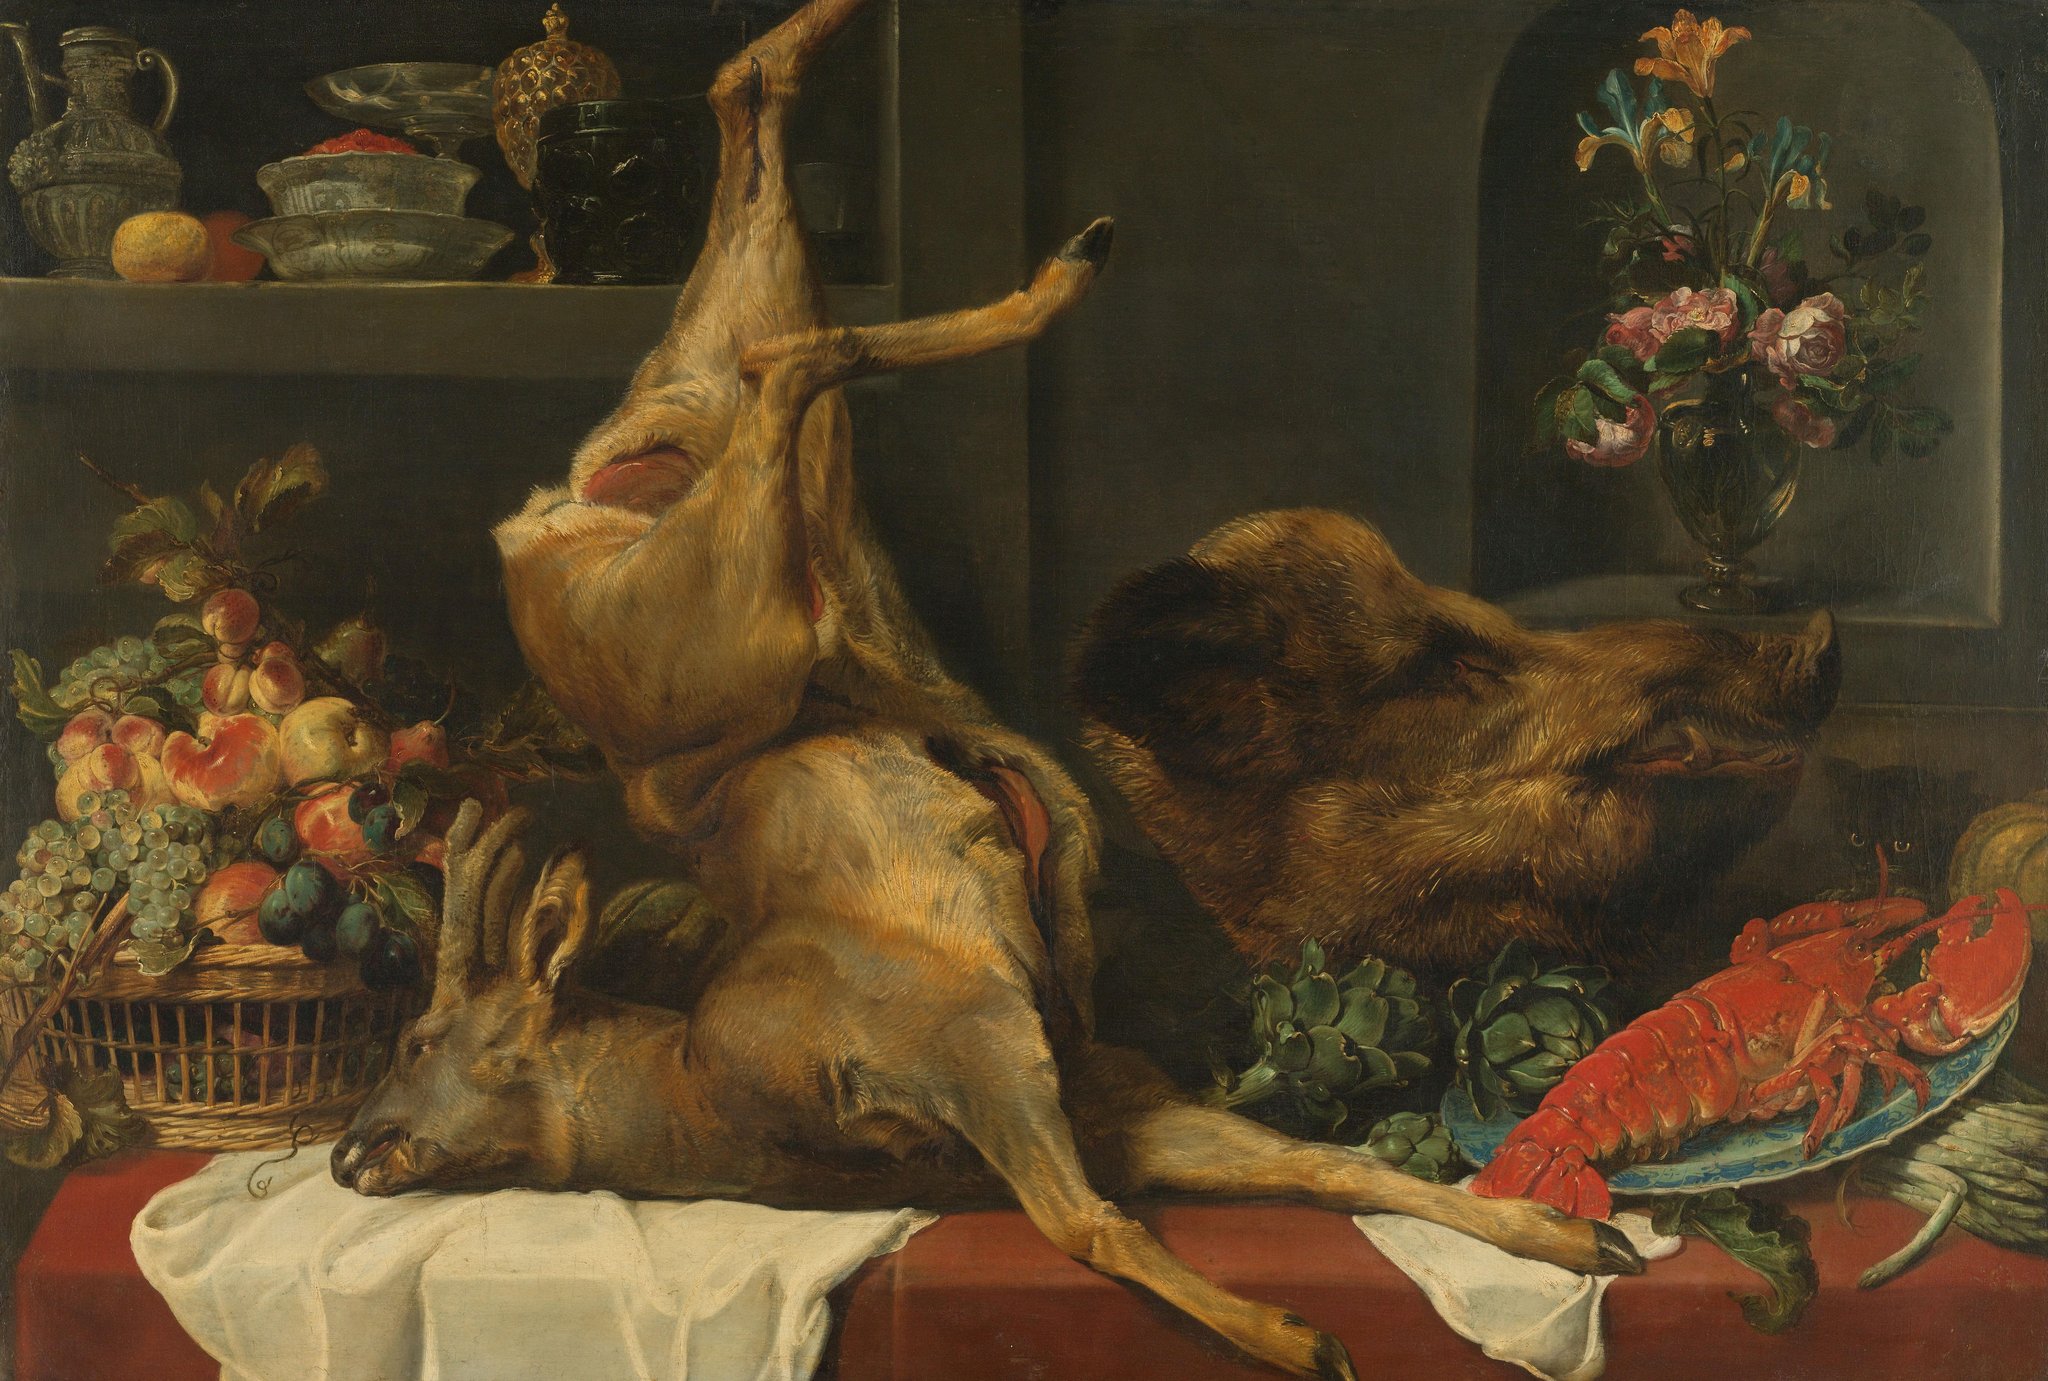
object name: painting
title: Larder Still life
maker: frans snijders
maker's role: draughtsman, painter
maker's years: 1579-1657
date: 1616-1625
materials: canvas, oil, paint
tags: spoils of the hunt, game, venison, still life of related objects, vegetables and fruit; still life of vegetables and fruit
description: Stilleven met groot dood wild, vruchten en bloemen. Op een tafel voor een muur liggen een mand met druiven, perziken en pruimen, een opengesneden ree opgehangen aan een poot, de kop van een wild zwijn, artisjokken, een schaal met een kreeft en een bos asperges. Een katje gluurt naar de kreeft. Op de achtergrond links in de muur een nis met vaatwerk, rechts een nis met een boeket bloemen in een glazen vaas.